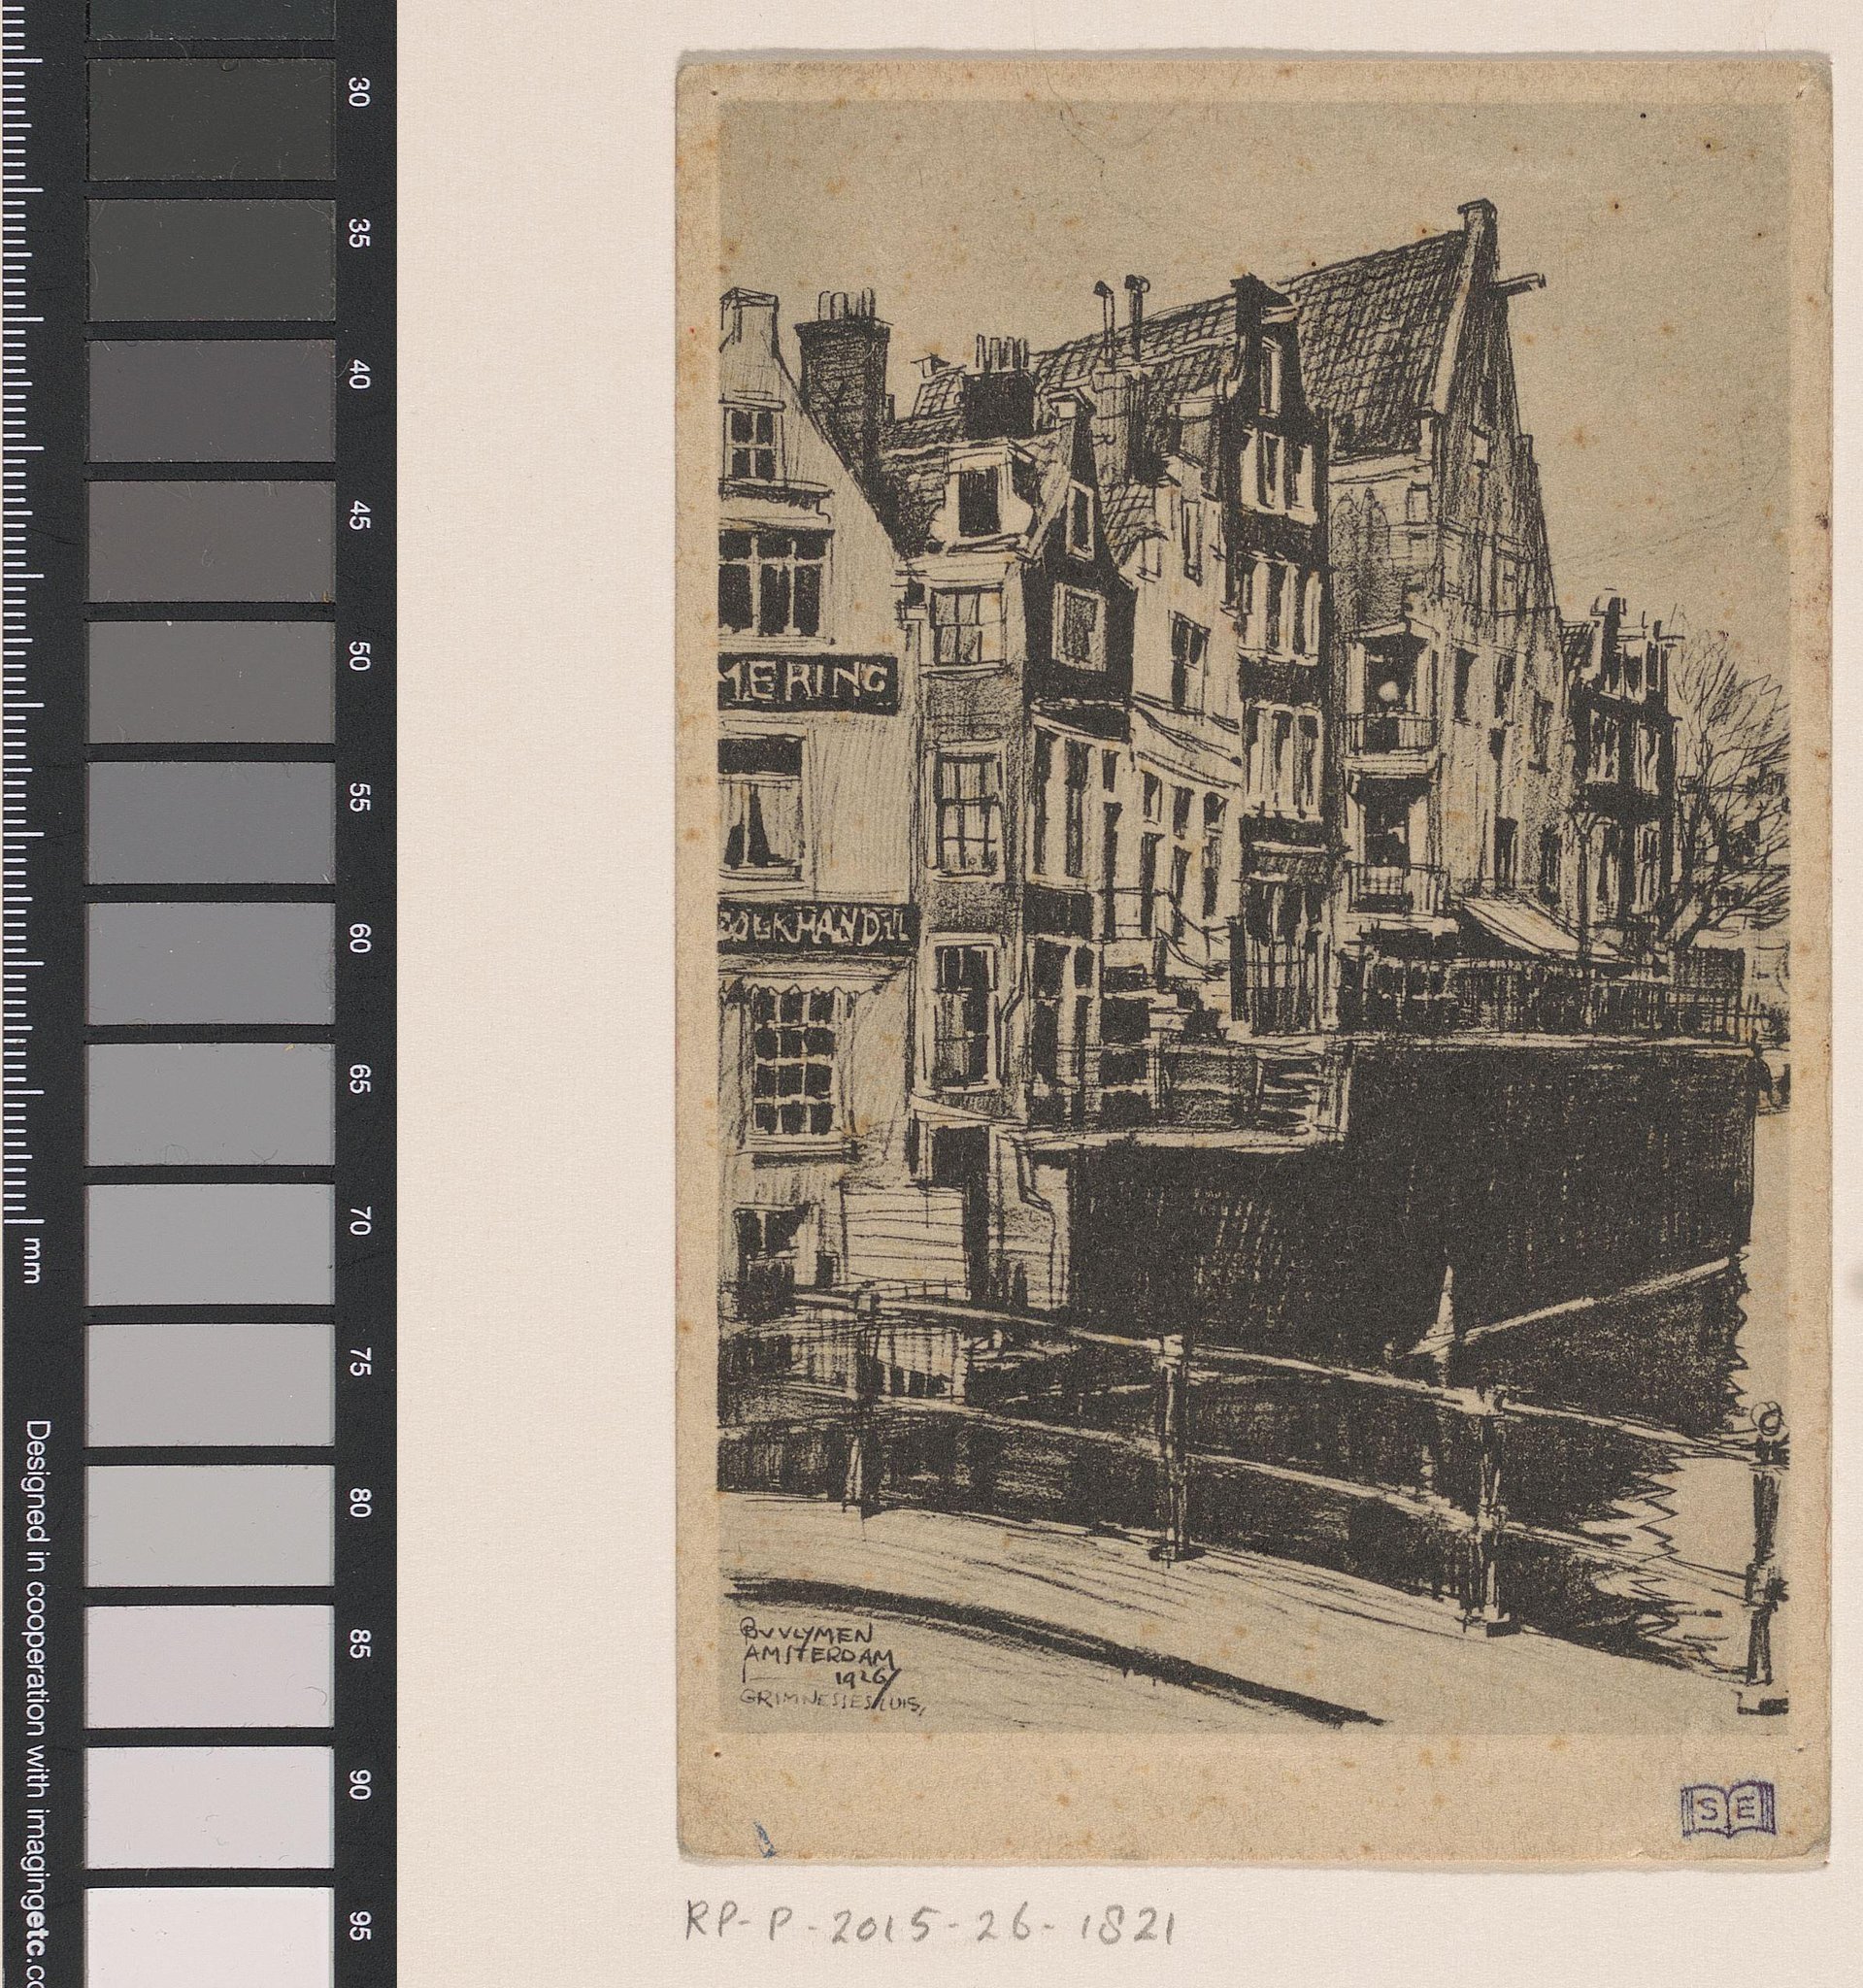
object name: photomechanical print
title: Grimnessesluis te Amsterdam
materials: paper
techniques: photograph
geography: amsterdam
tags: façade (of house or building), book-shop, bookseller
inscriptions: collector's mark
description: De Grimnessesluis gezien vanaf de Oude Turfmarkt naar Oudezijds Achterburgwal. Links de achterzijde van het pand van boekhandel J. Emmering aan de Langebrugsteeg.